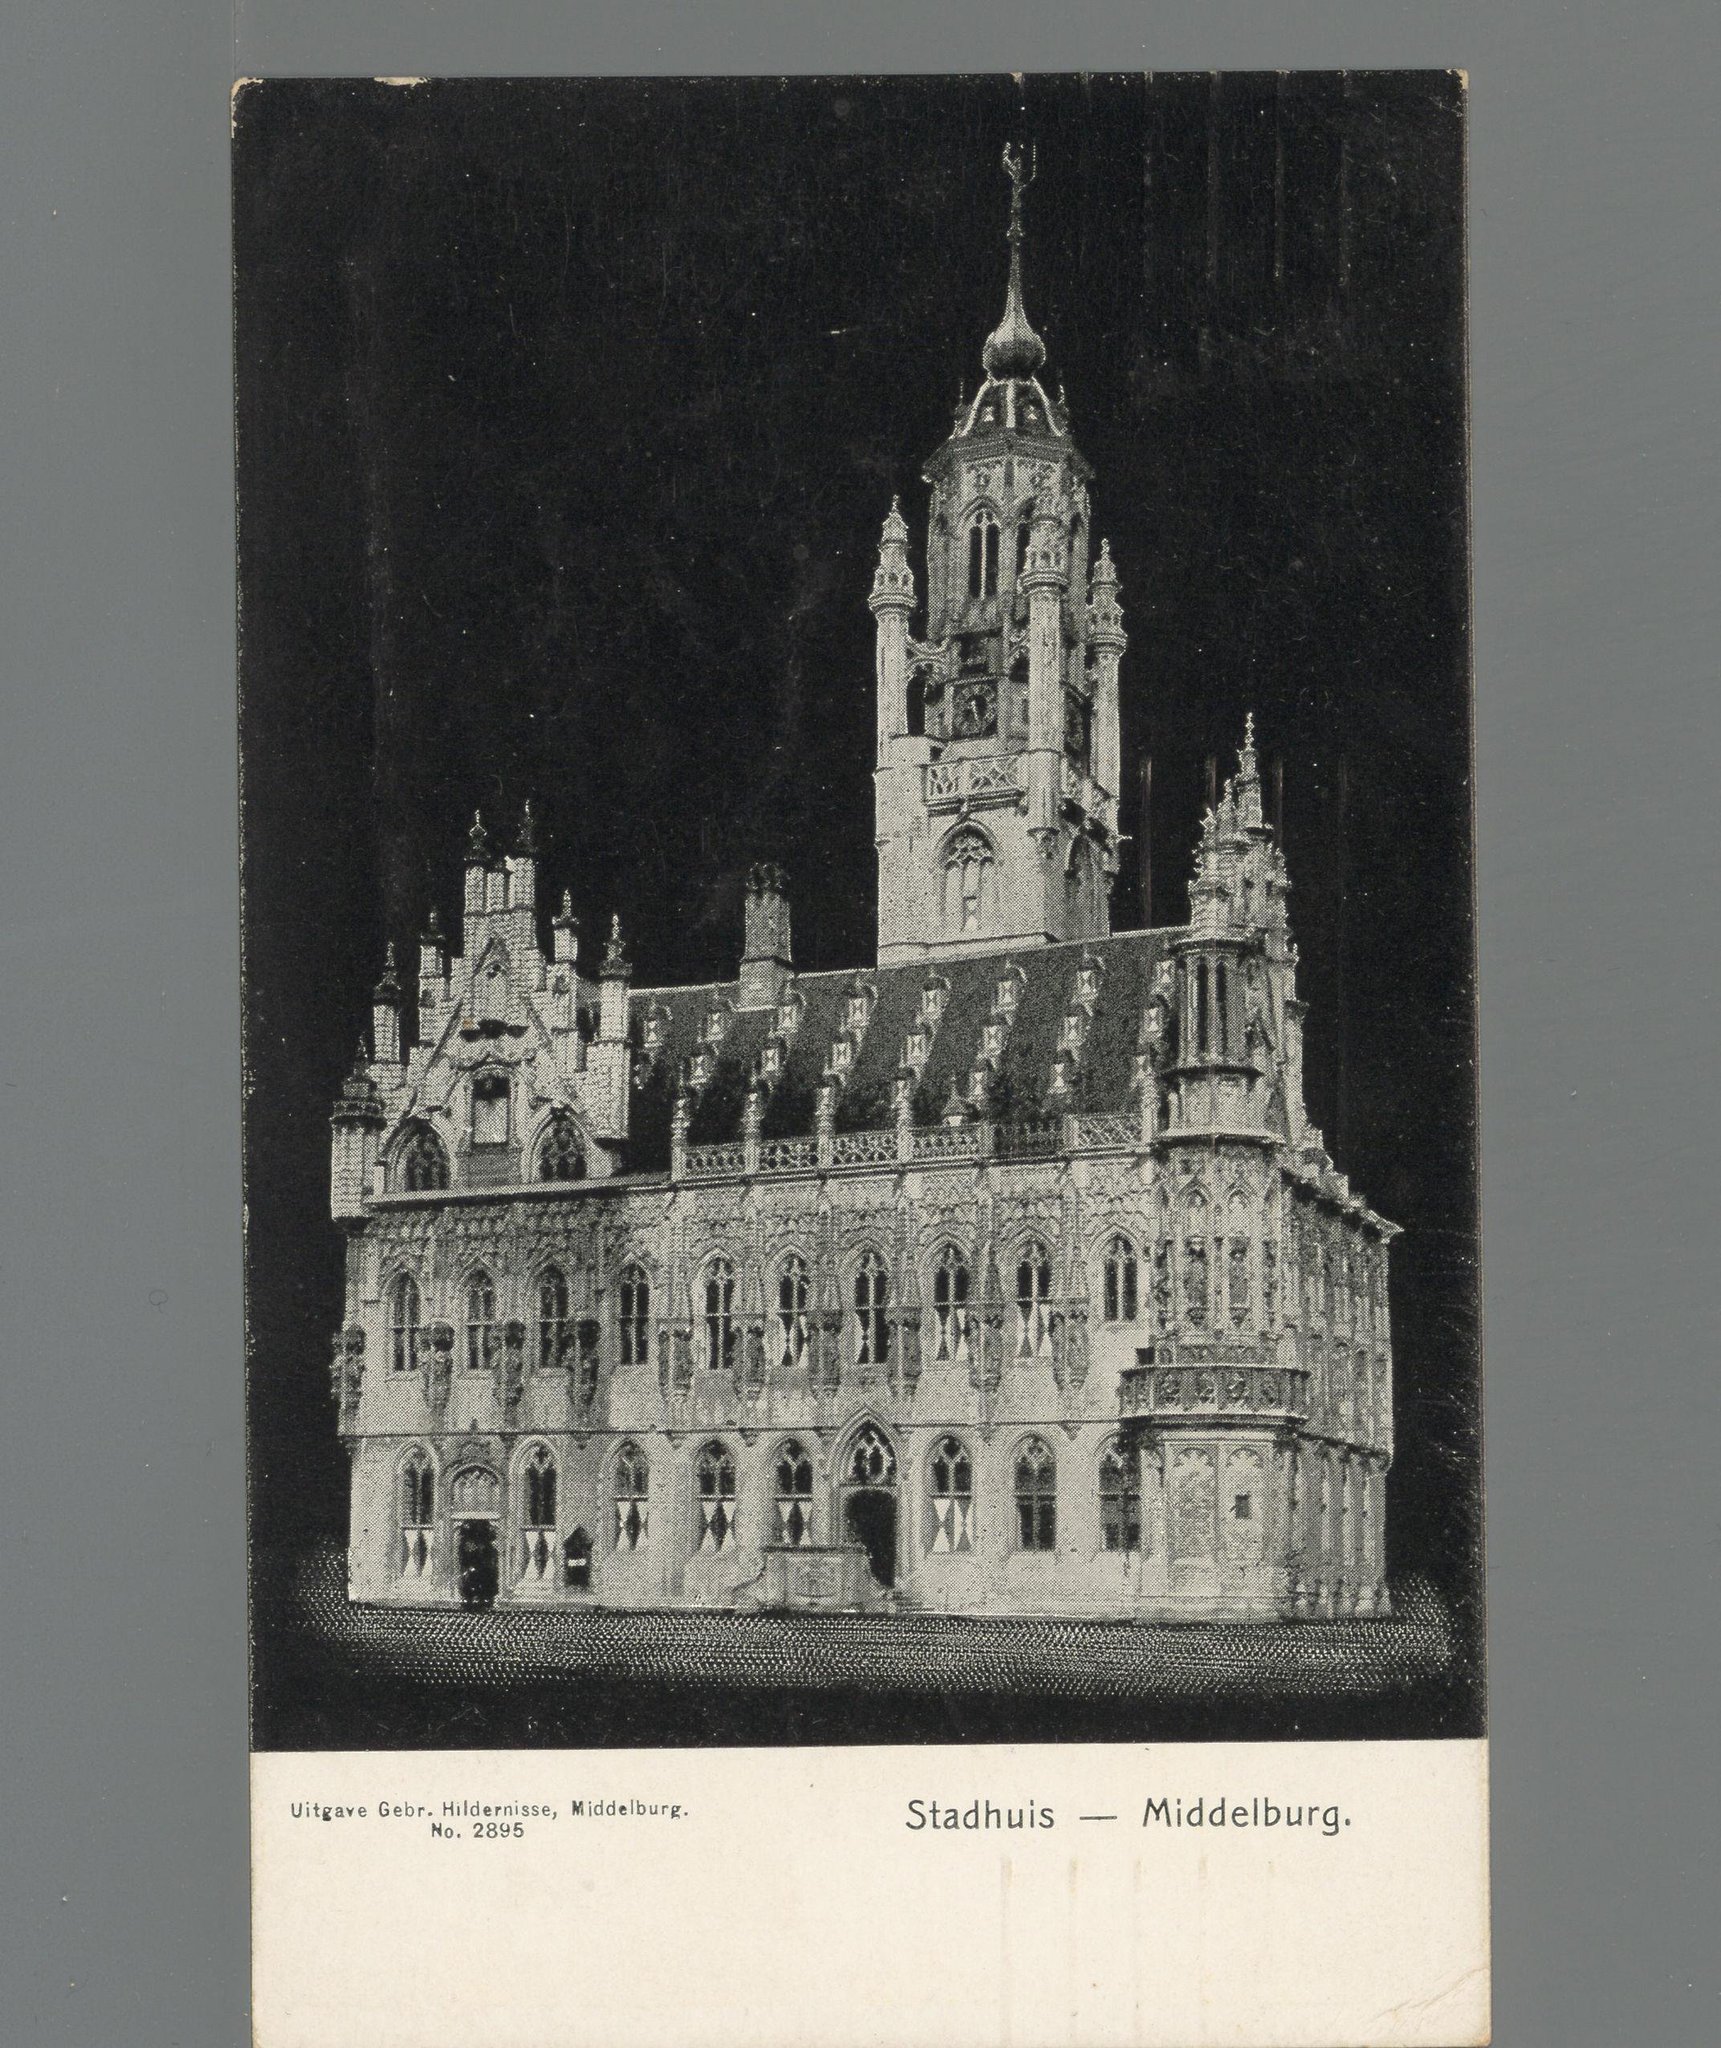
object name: ansichtkaart, prentbriefkaart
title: Stadhuis - Middelburg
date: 1905-1910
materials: cardboard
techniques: writing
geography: middelburg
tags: townhall, model ~ architecture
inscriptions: postage stamp